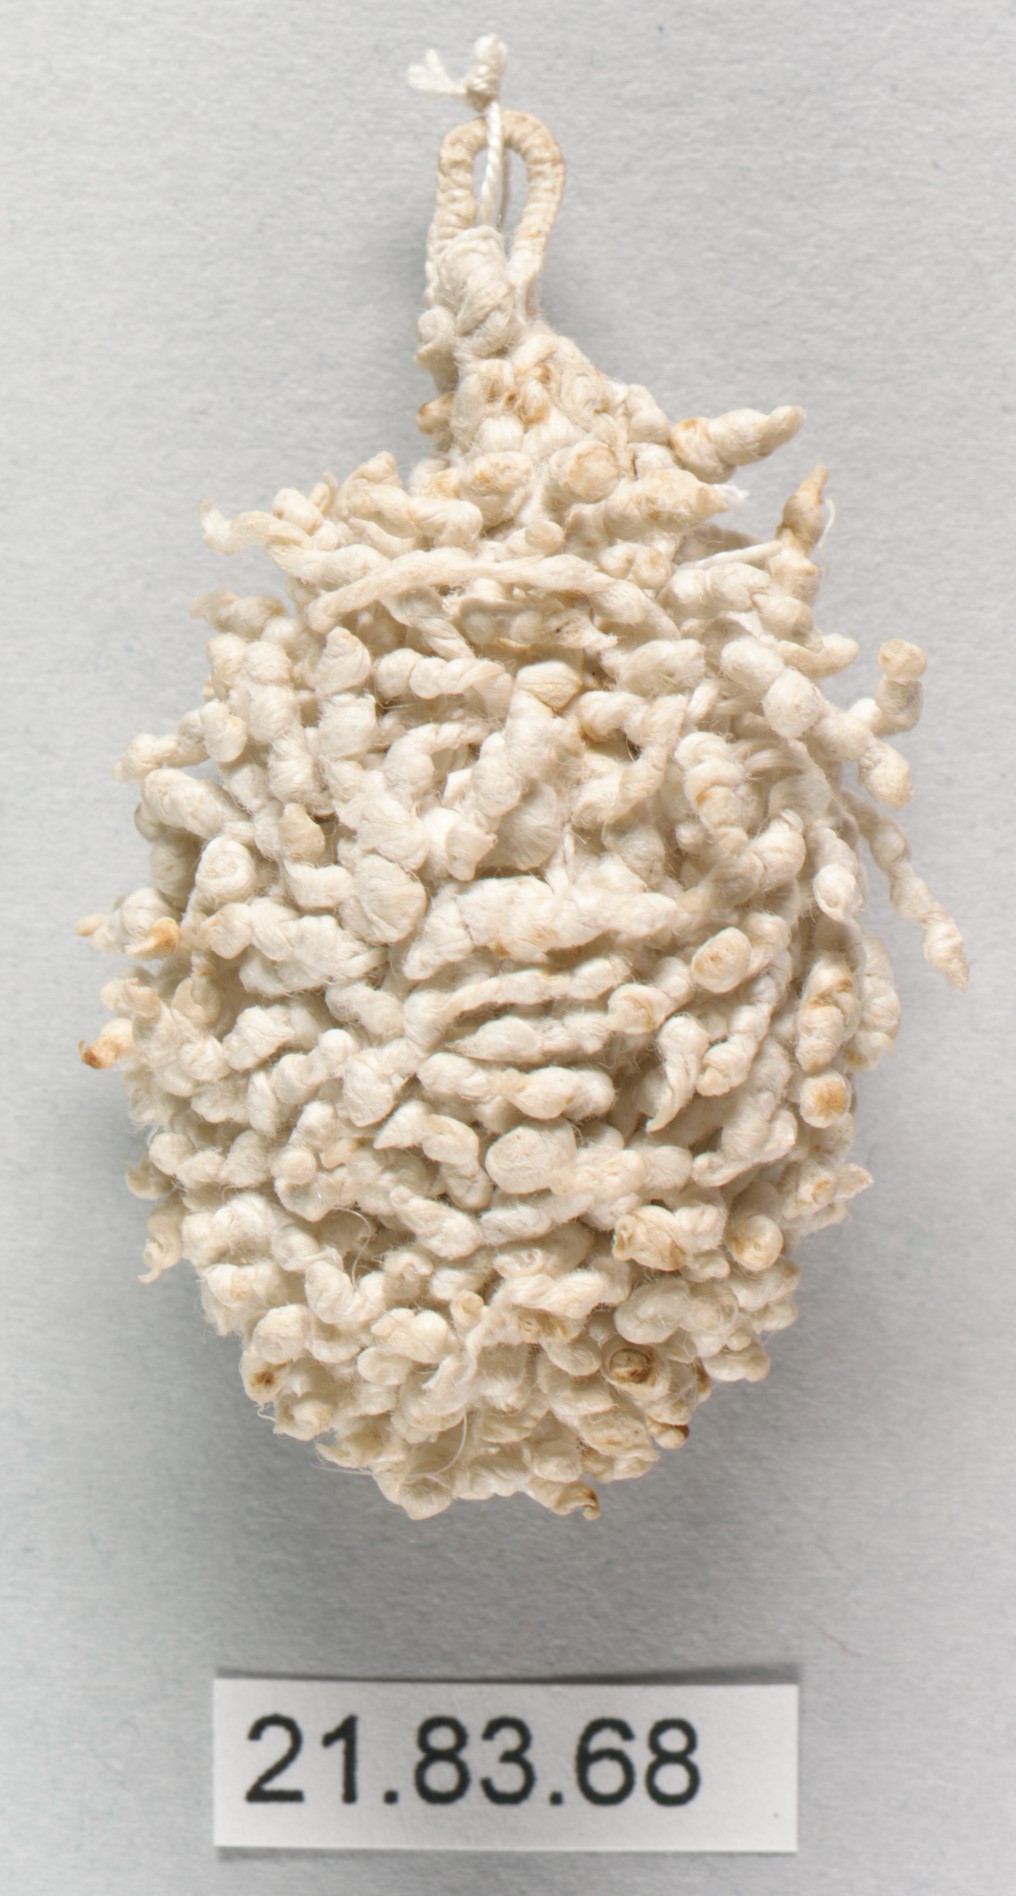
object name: tassel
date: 1601-1700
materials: linen